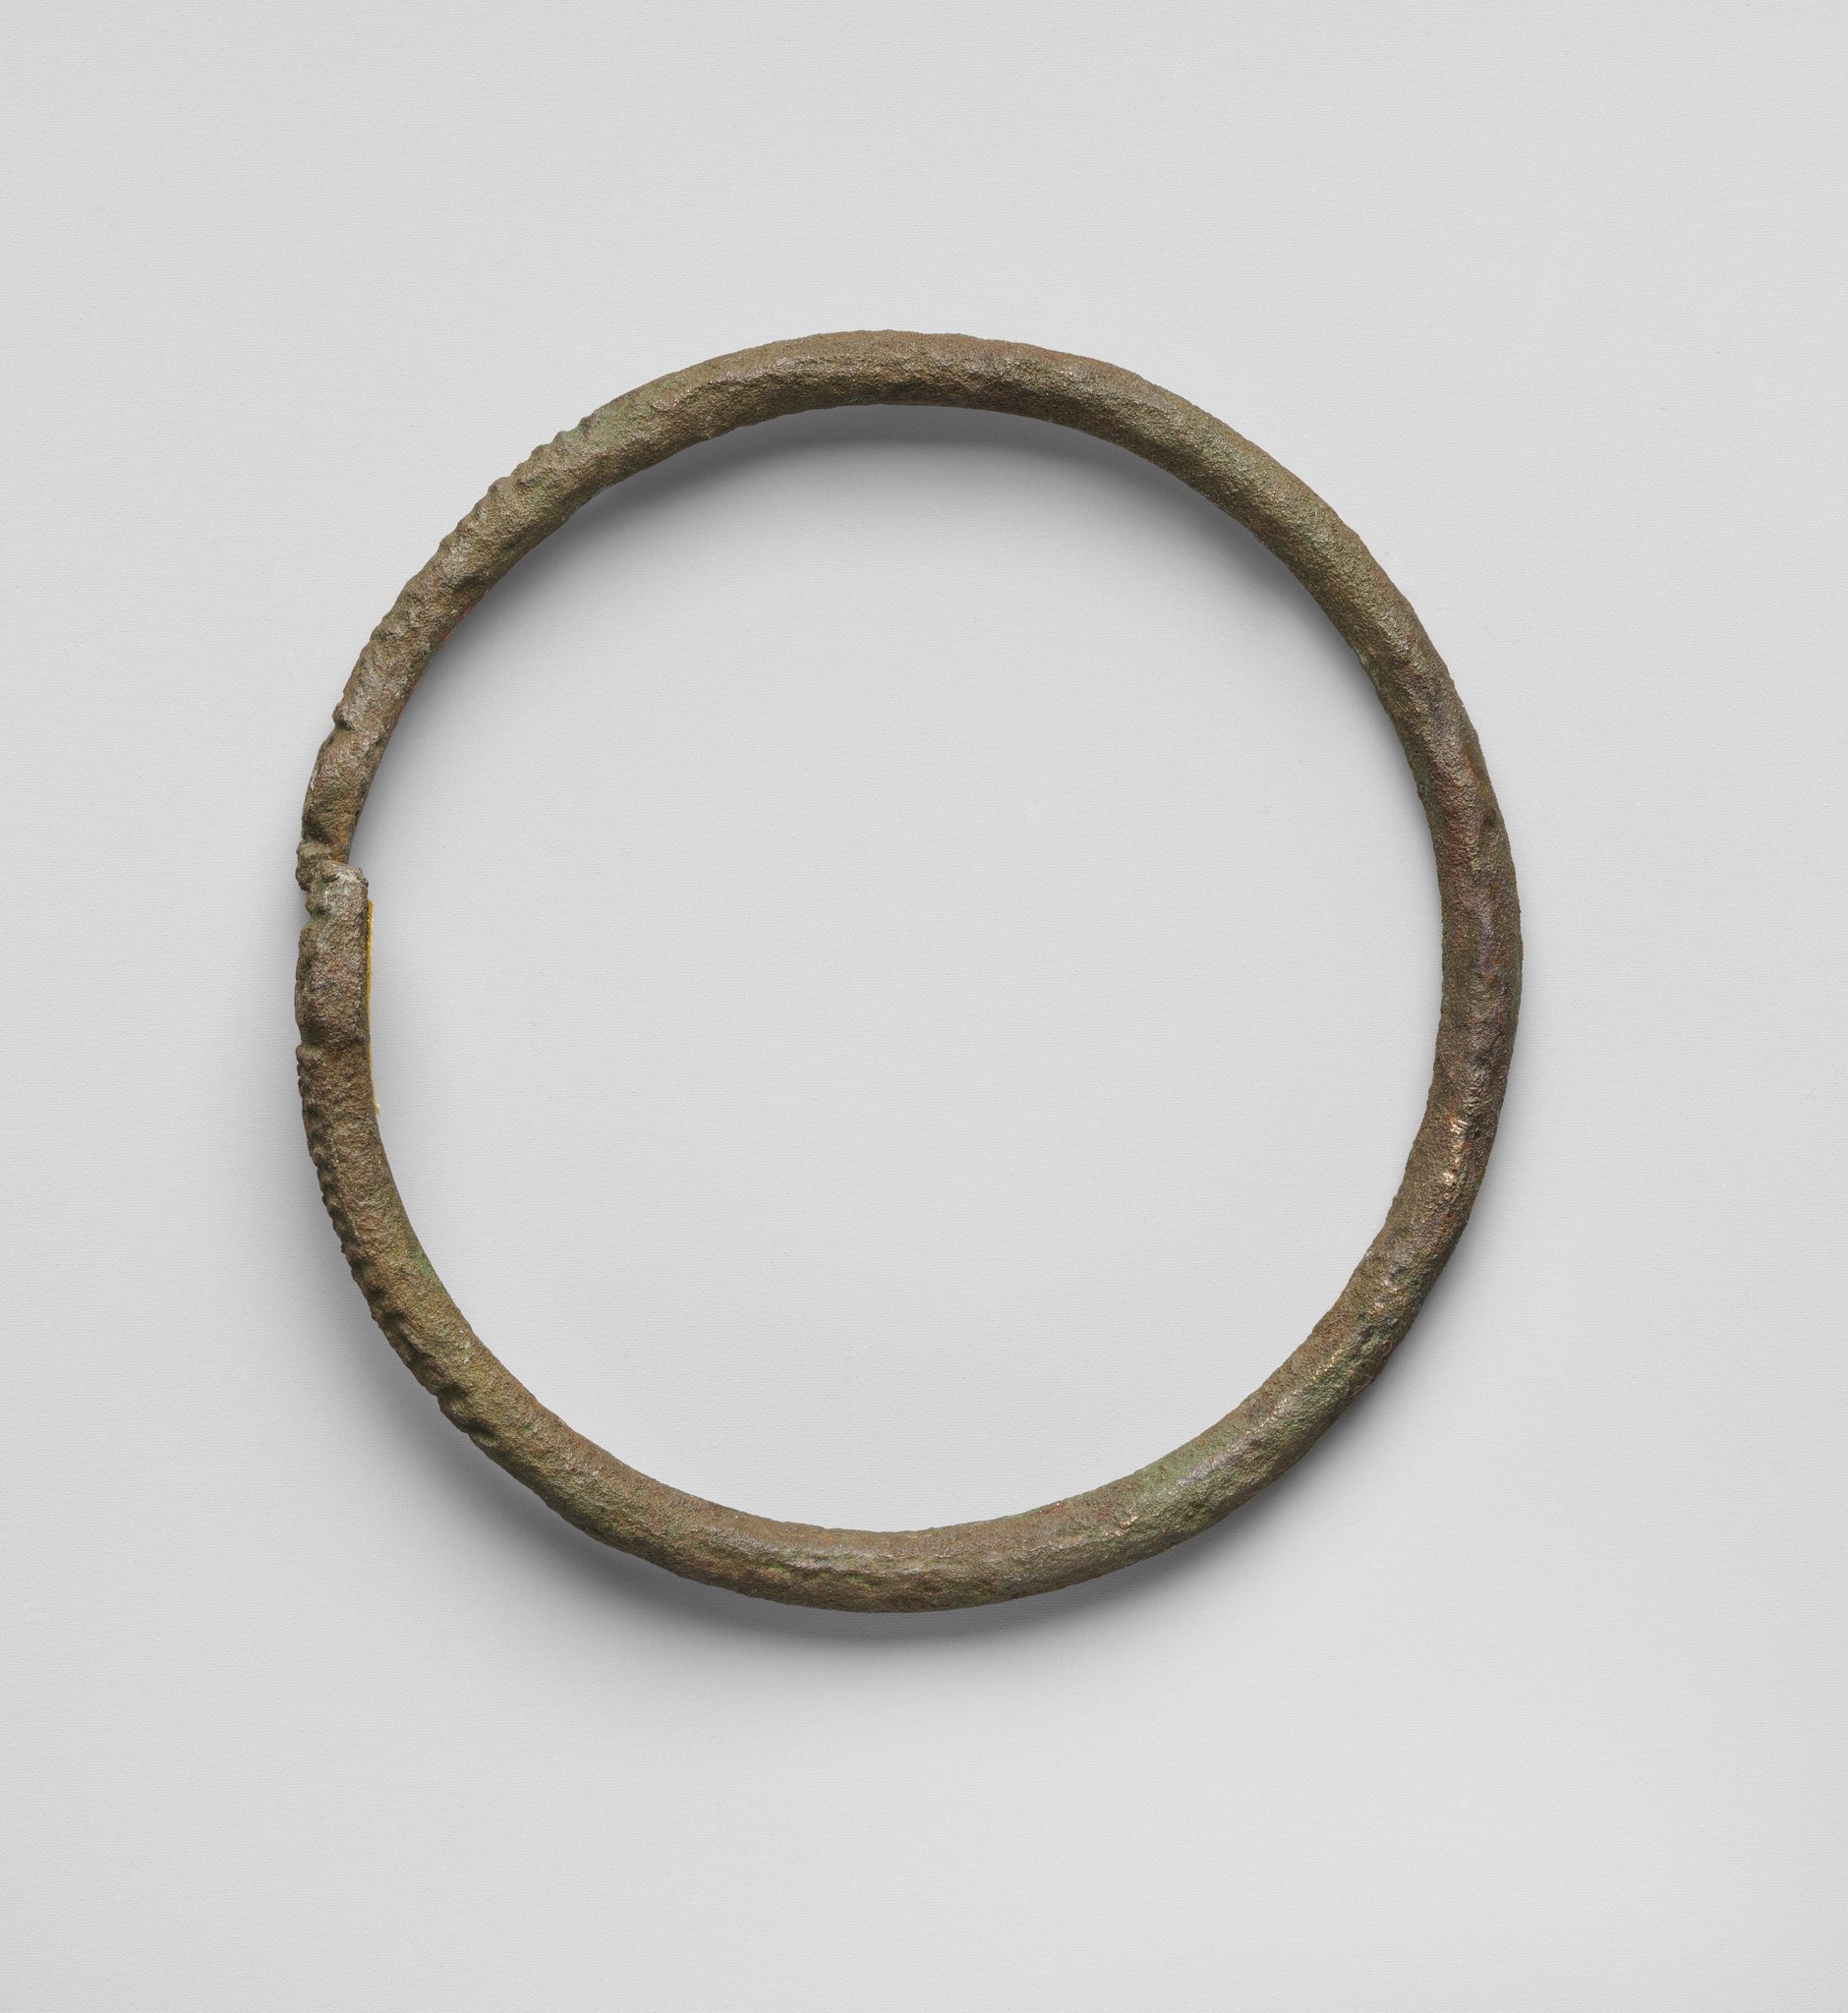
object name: bracelet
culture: iranian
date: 900-801 BCE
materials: bronze, copper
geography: iran